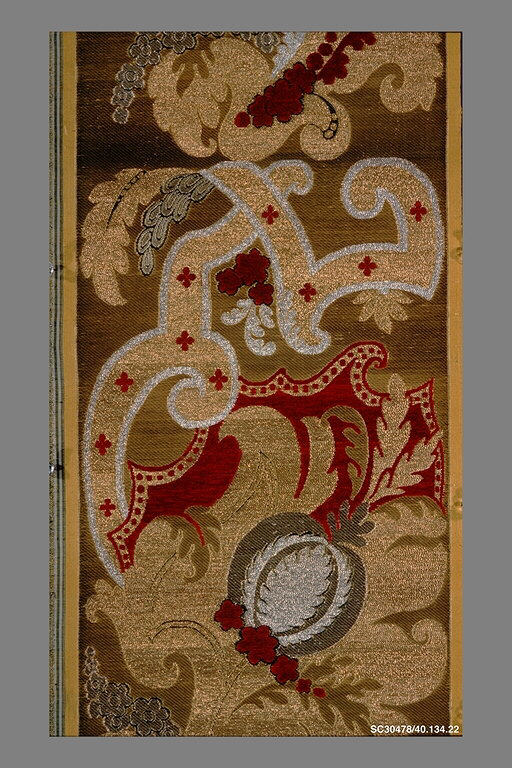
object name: vestment border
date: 1826-1850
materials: metal thread, silk